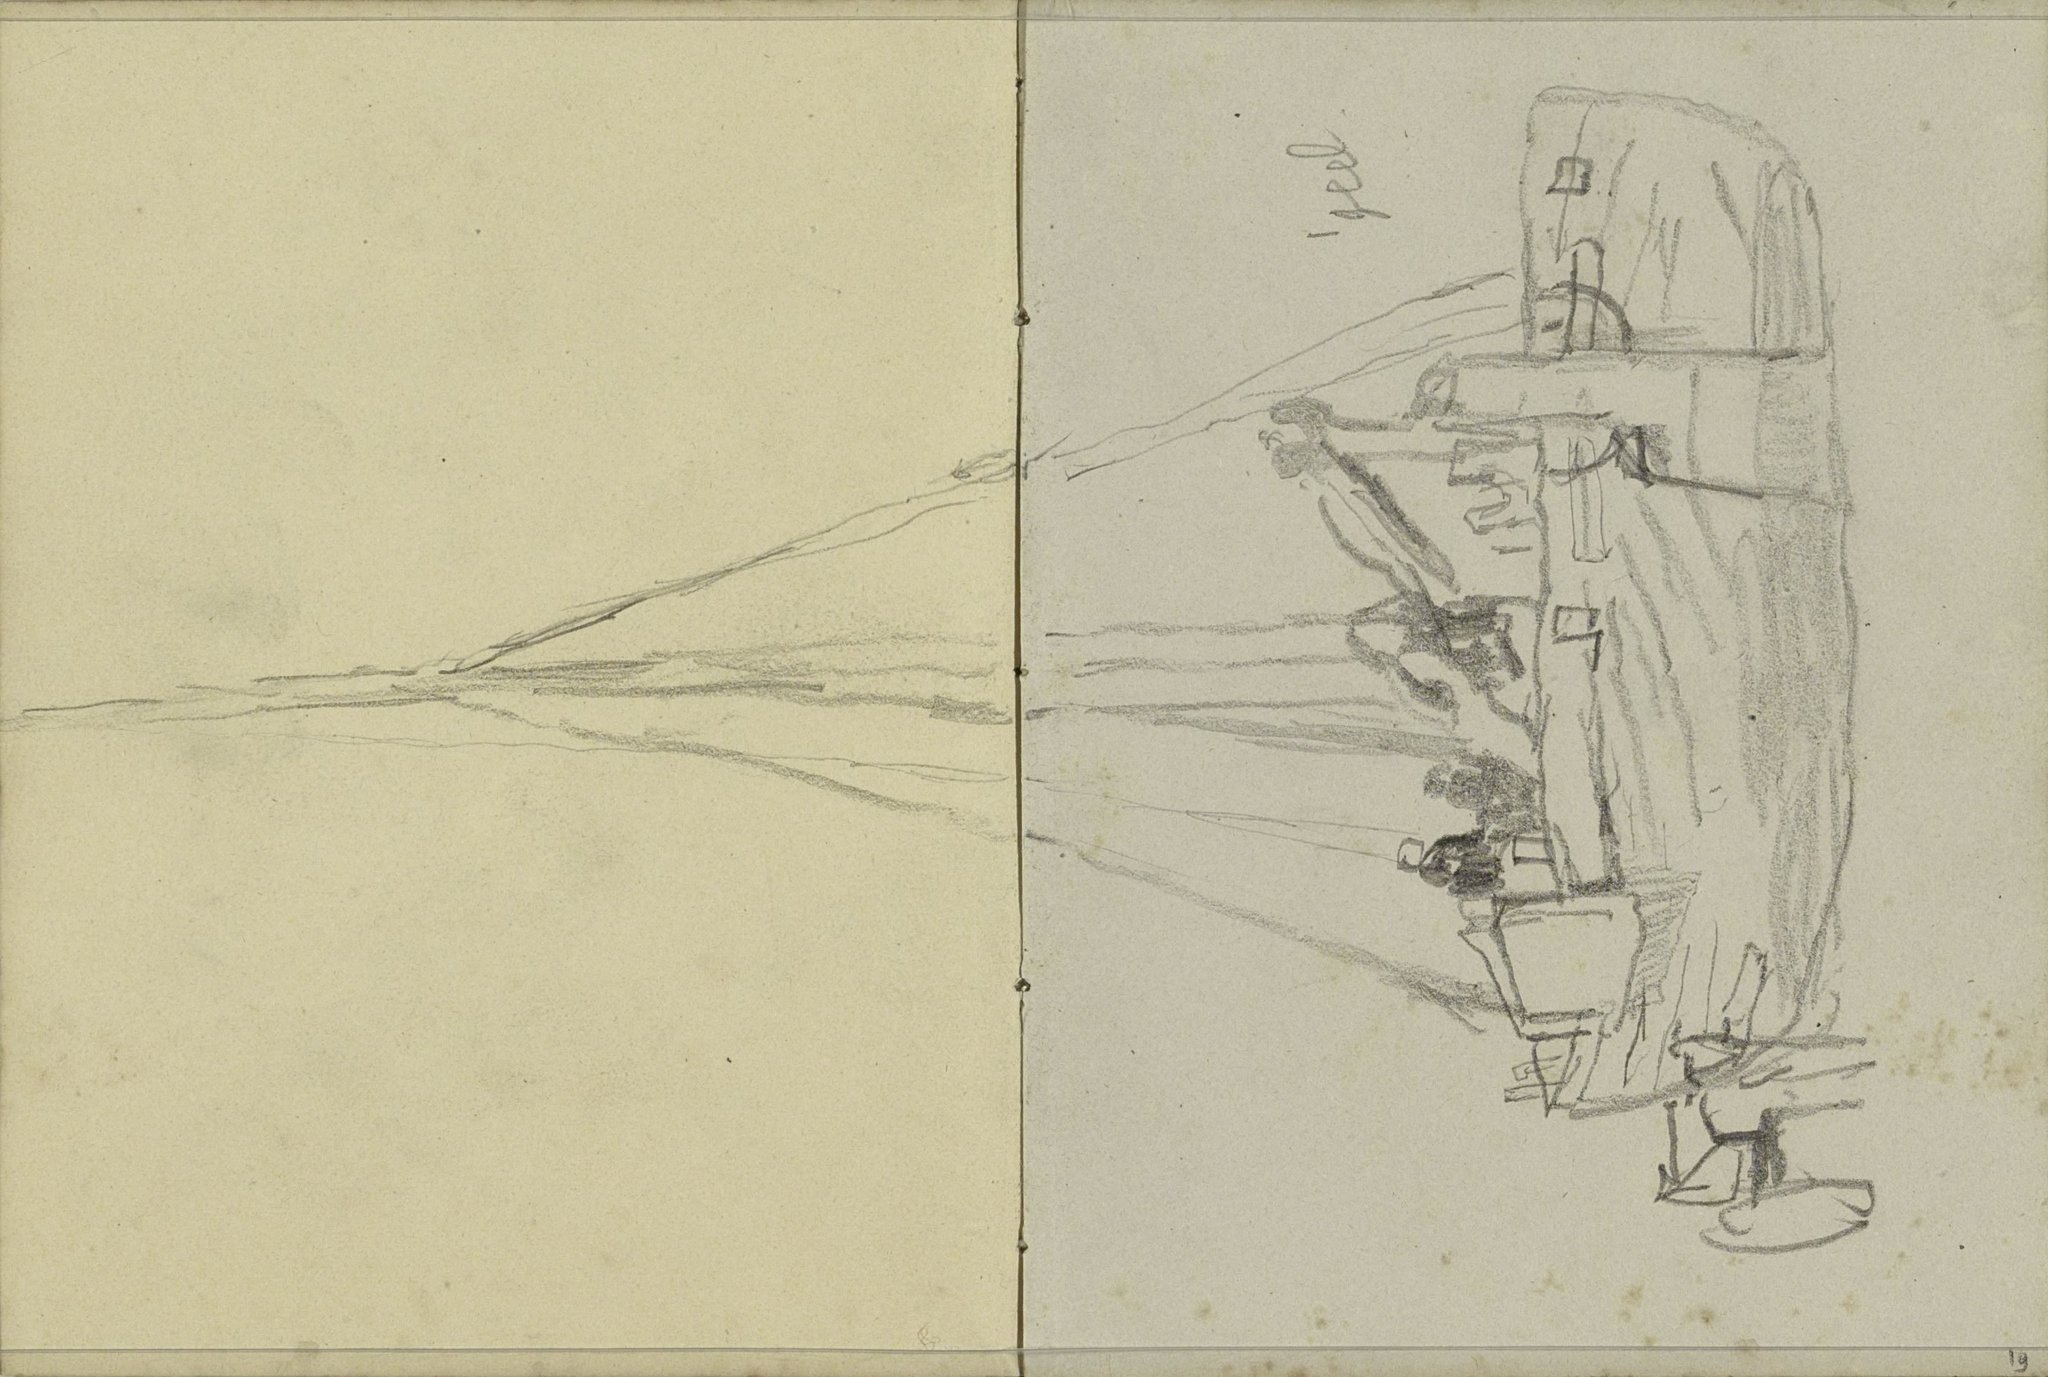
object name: sketchbook leaf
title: Figuren op een aangemeerd zeilschip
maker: johan hendrik weissenbruch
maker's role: draughtsman, painter, print maker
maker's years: 1824-1903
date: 1834-1903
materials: paper, pencil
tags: sailing-ship, sailing-boat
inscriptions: kleurnotitie, handgeschreven in potlood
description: Blad 18 verso en 19 recto uit een schetsboek met 34 bladen.